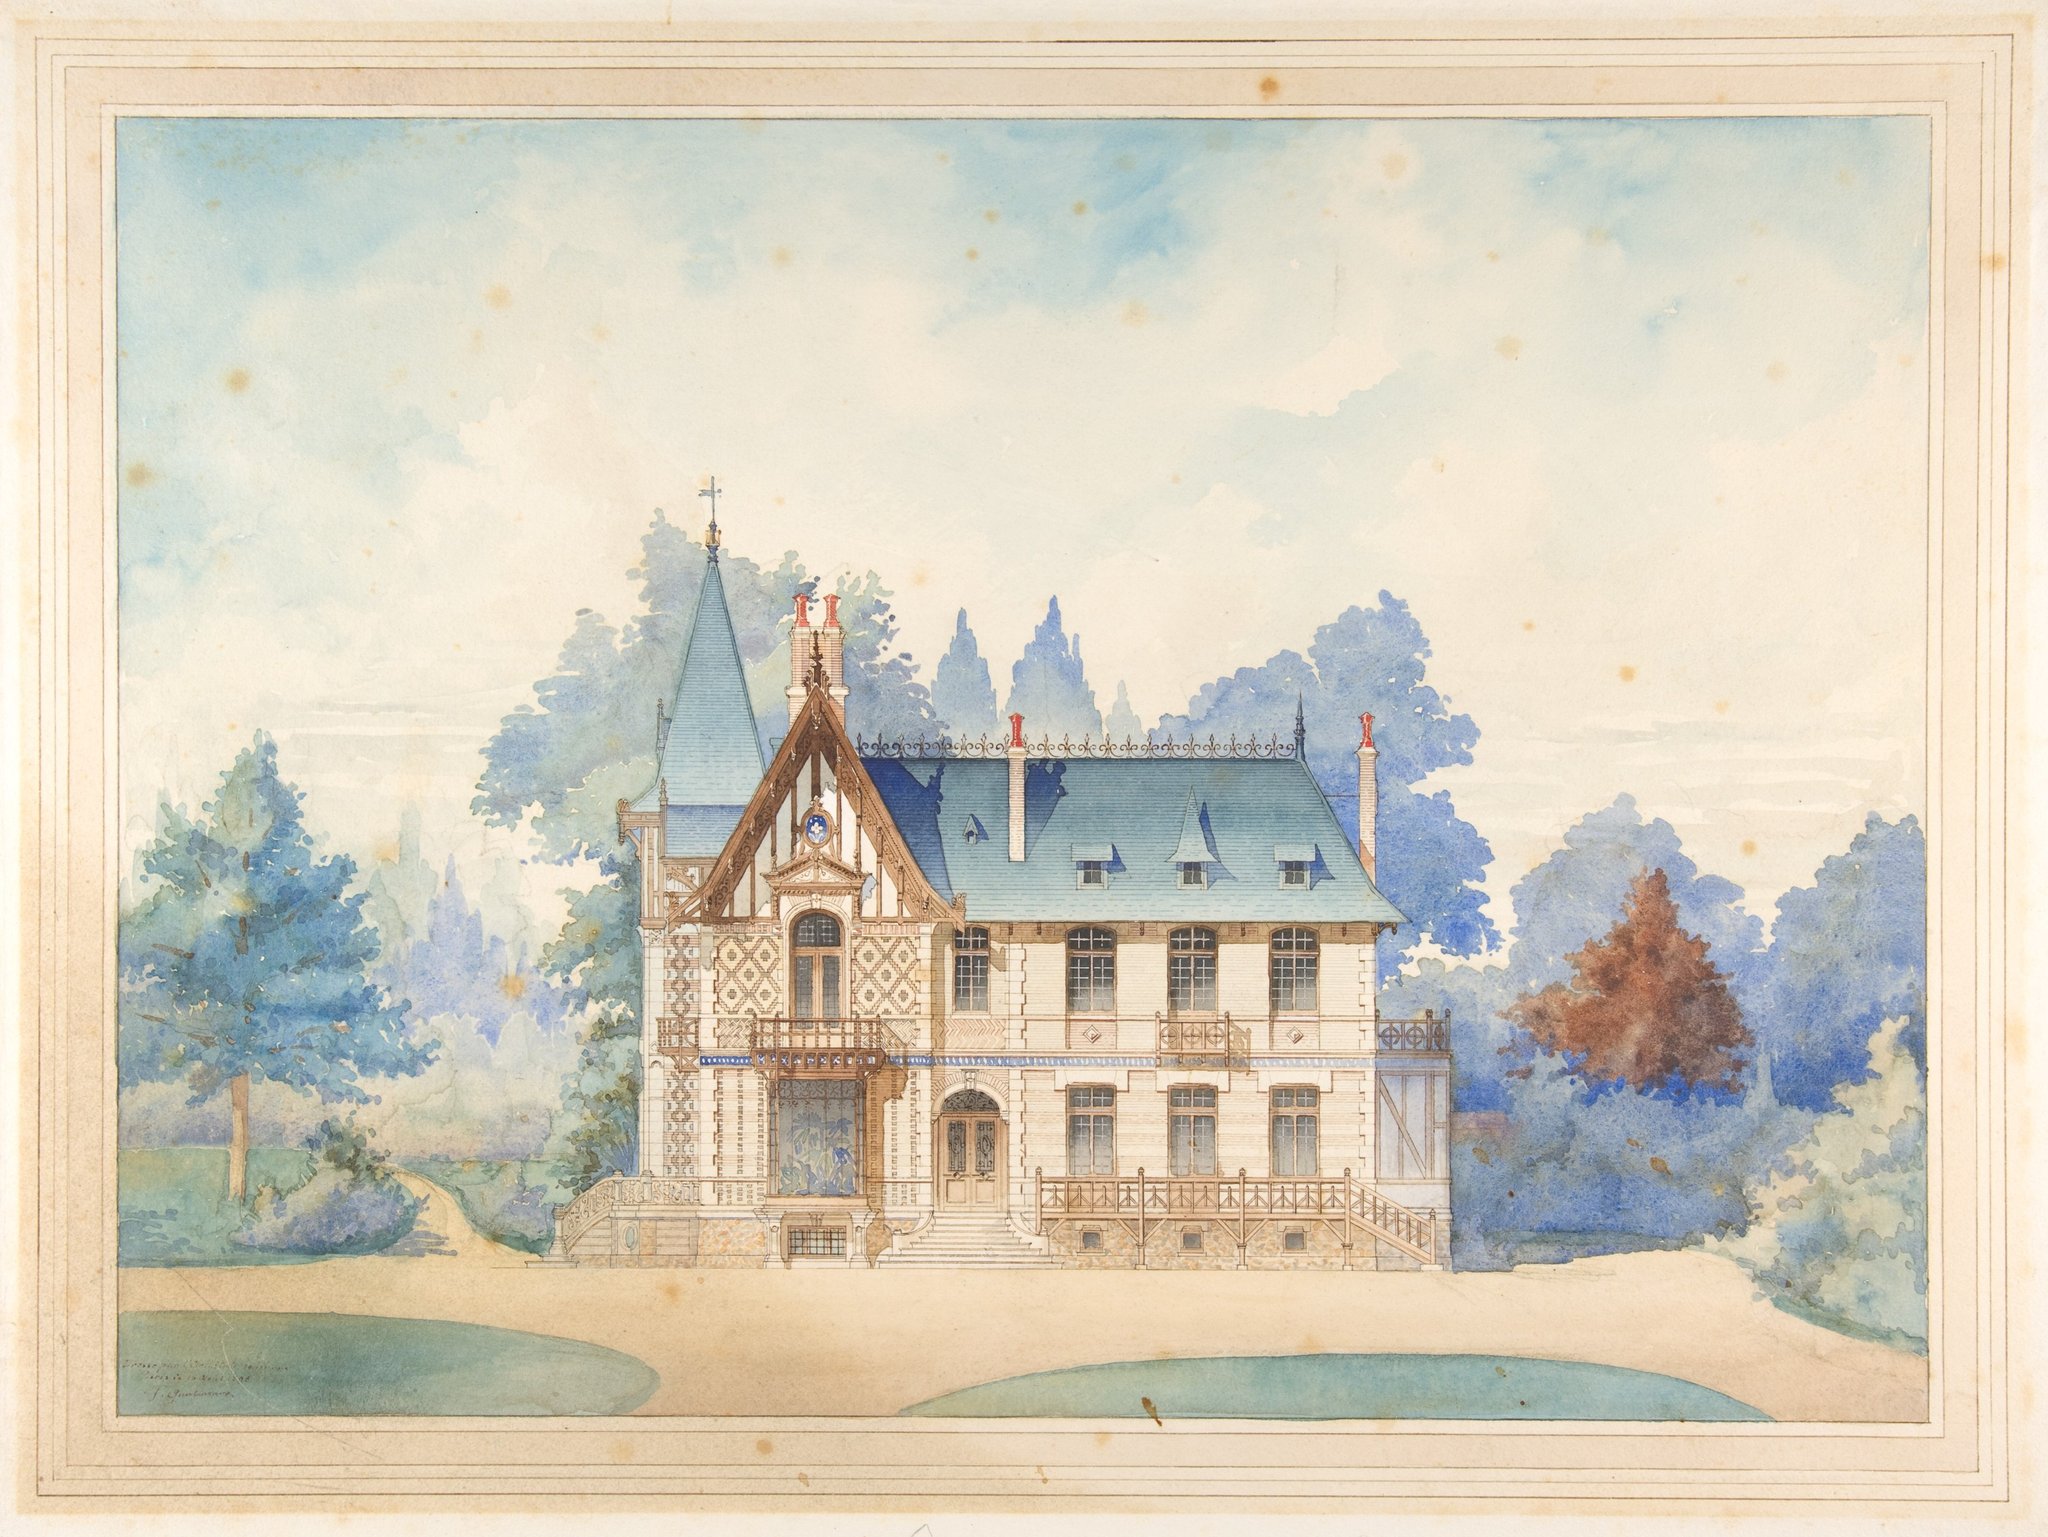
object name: drawing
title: View of a Country House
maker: anonymous, french, 19th century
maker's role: artist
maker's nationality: french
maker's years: 1800-1900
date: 1898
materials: watercolor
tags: houses